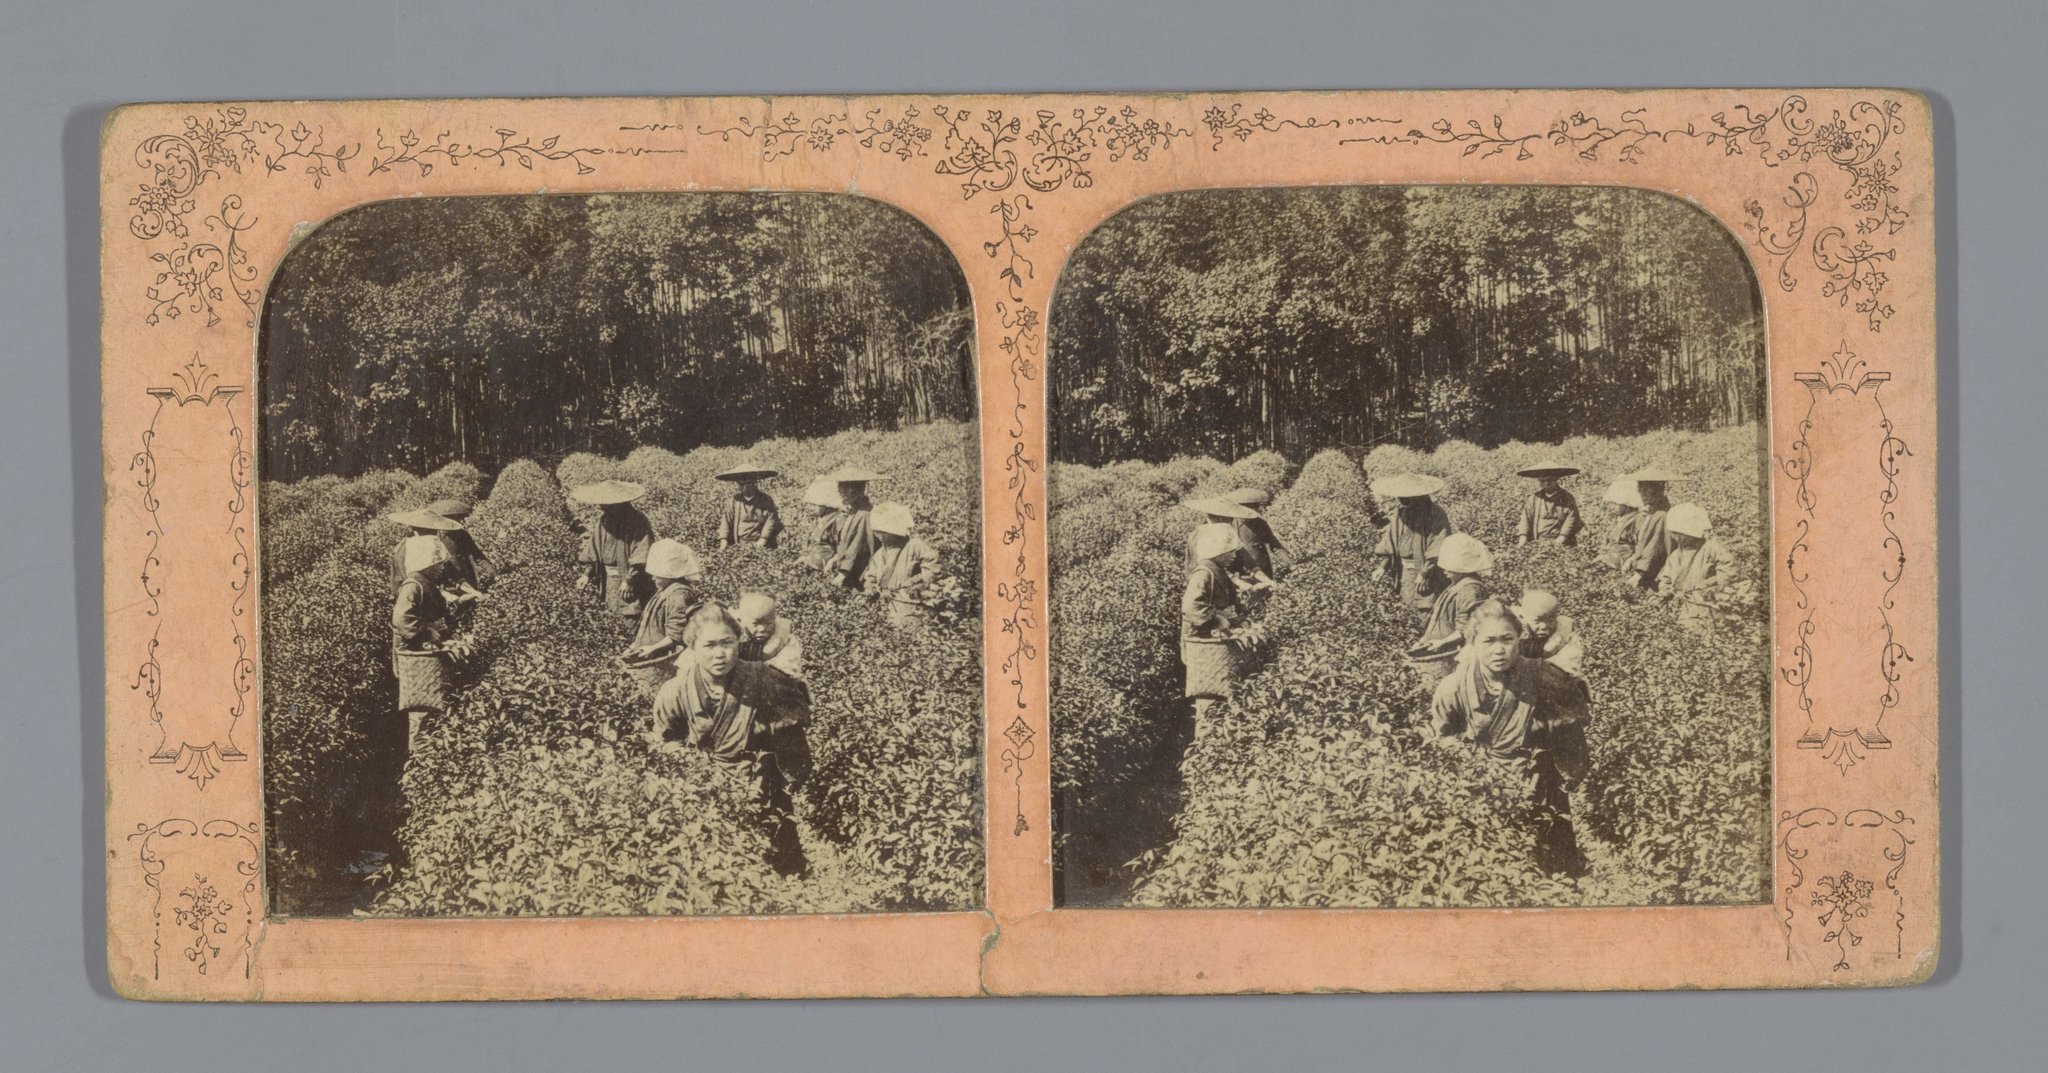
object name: tissue stereograph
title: Vrouwen op een plantage in Zuidoost-Azië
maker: Anonymous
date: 1865-1875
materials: cardboard, paper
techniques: albumen print, hand coloring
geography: asia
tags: plantation